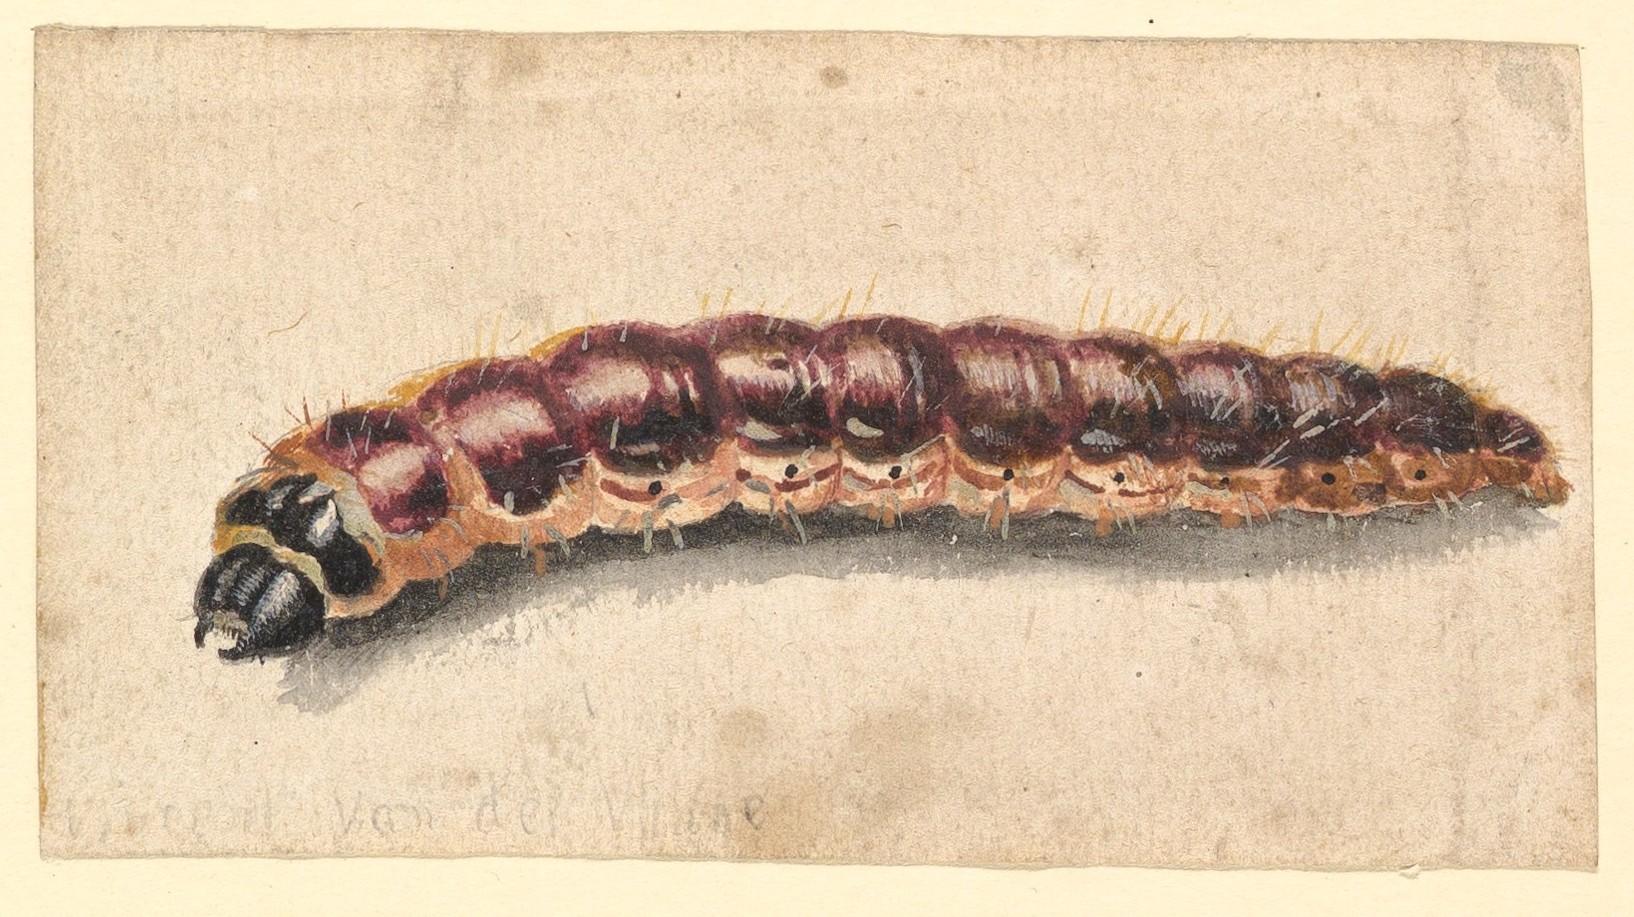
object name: drawing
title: A Caterpillar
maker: vincent laurensz van der vinne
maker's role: artist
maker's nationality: dutch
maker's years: 1628-1702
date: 1667-1700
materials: gum arabic, watercolor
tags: insects